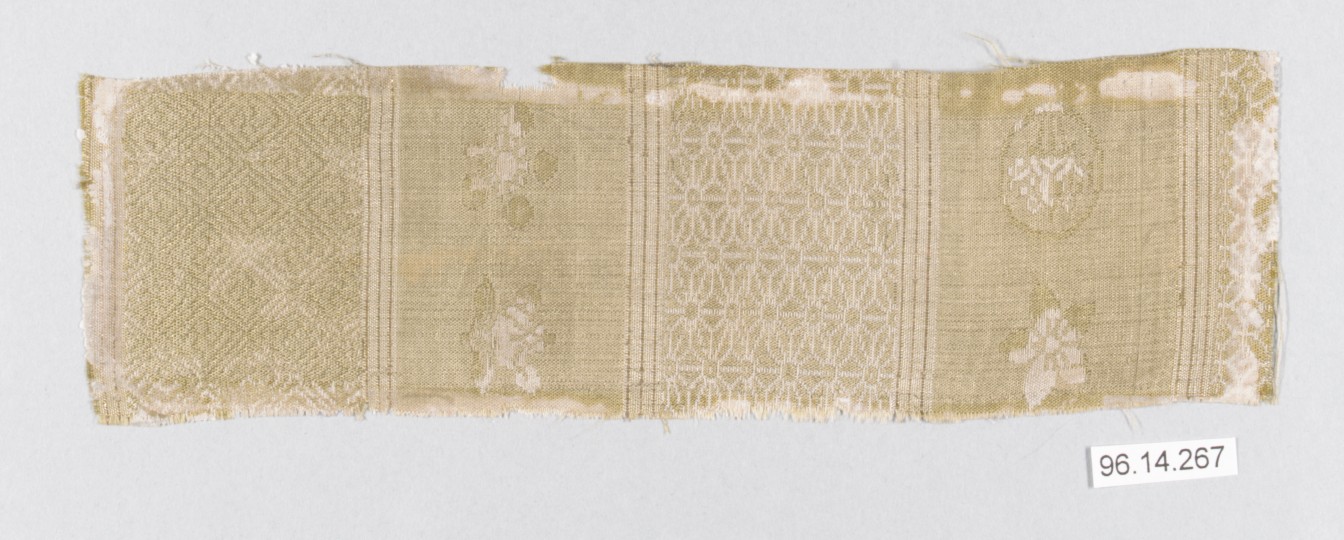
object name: piece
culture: japanese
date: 1701-1900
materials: silk